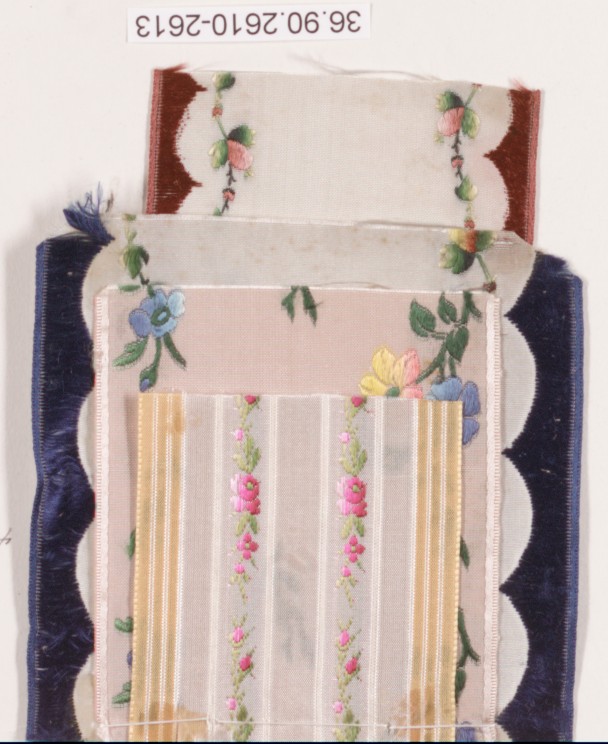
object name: ribbon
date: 1801-1900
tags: flowers